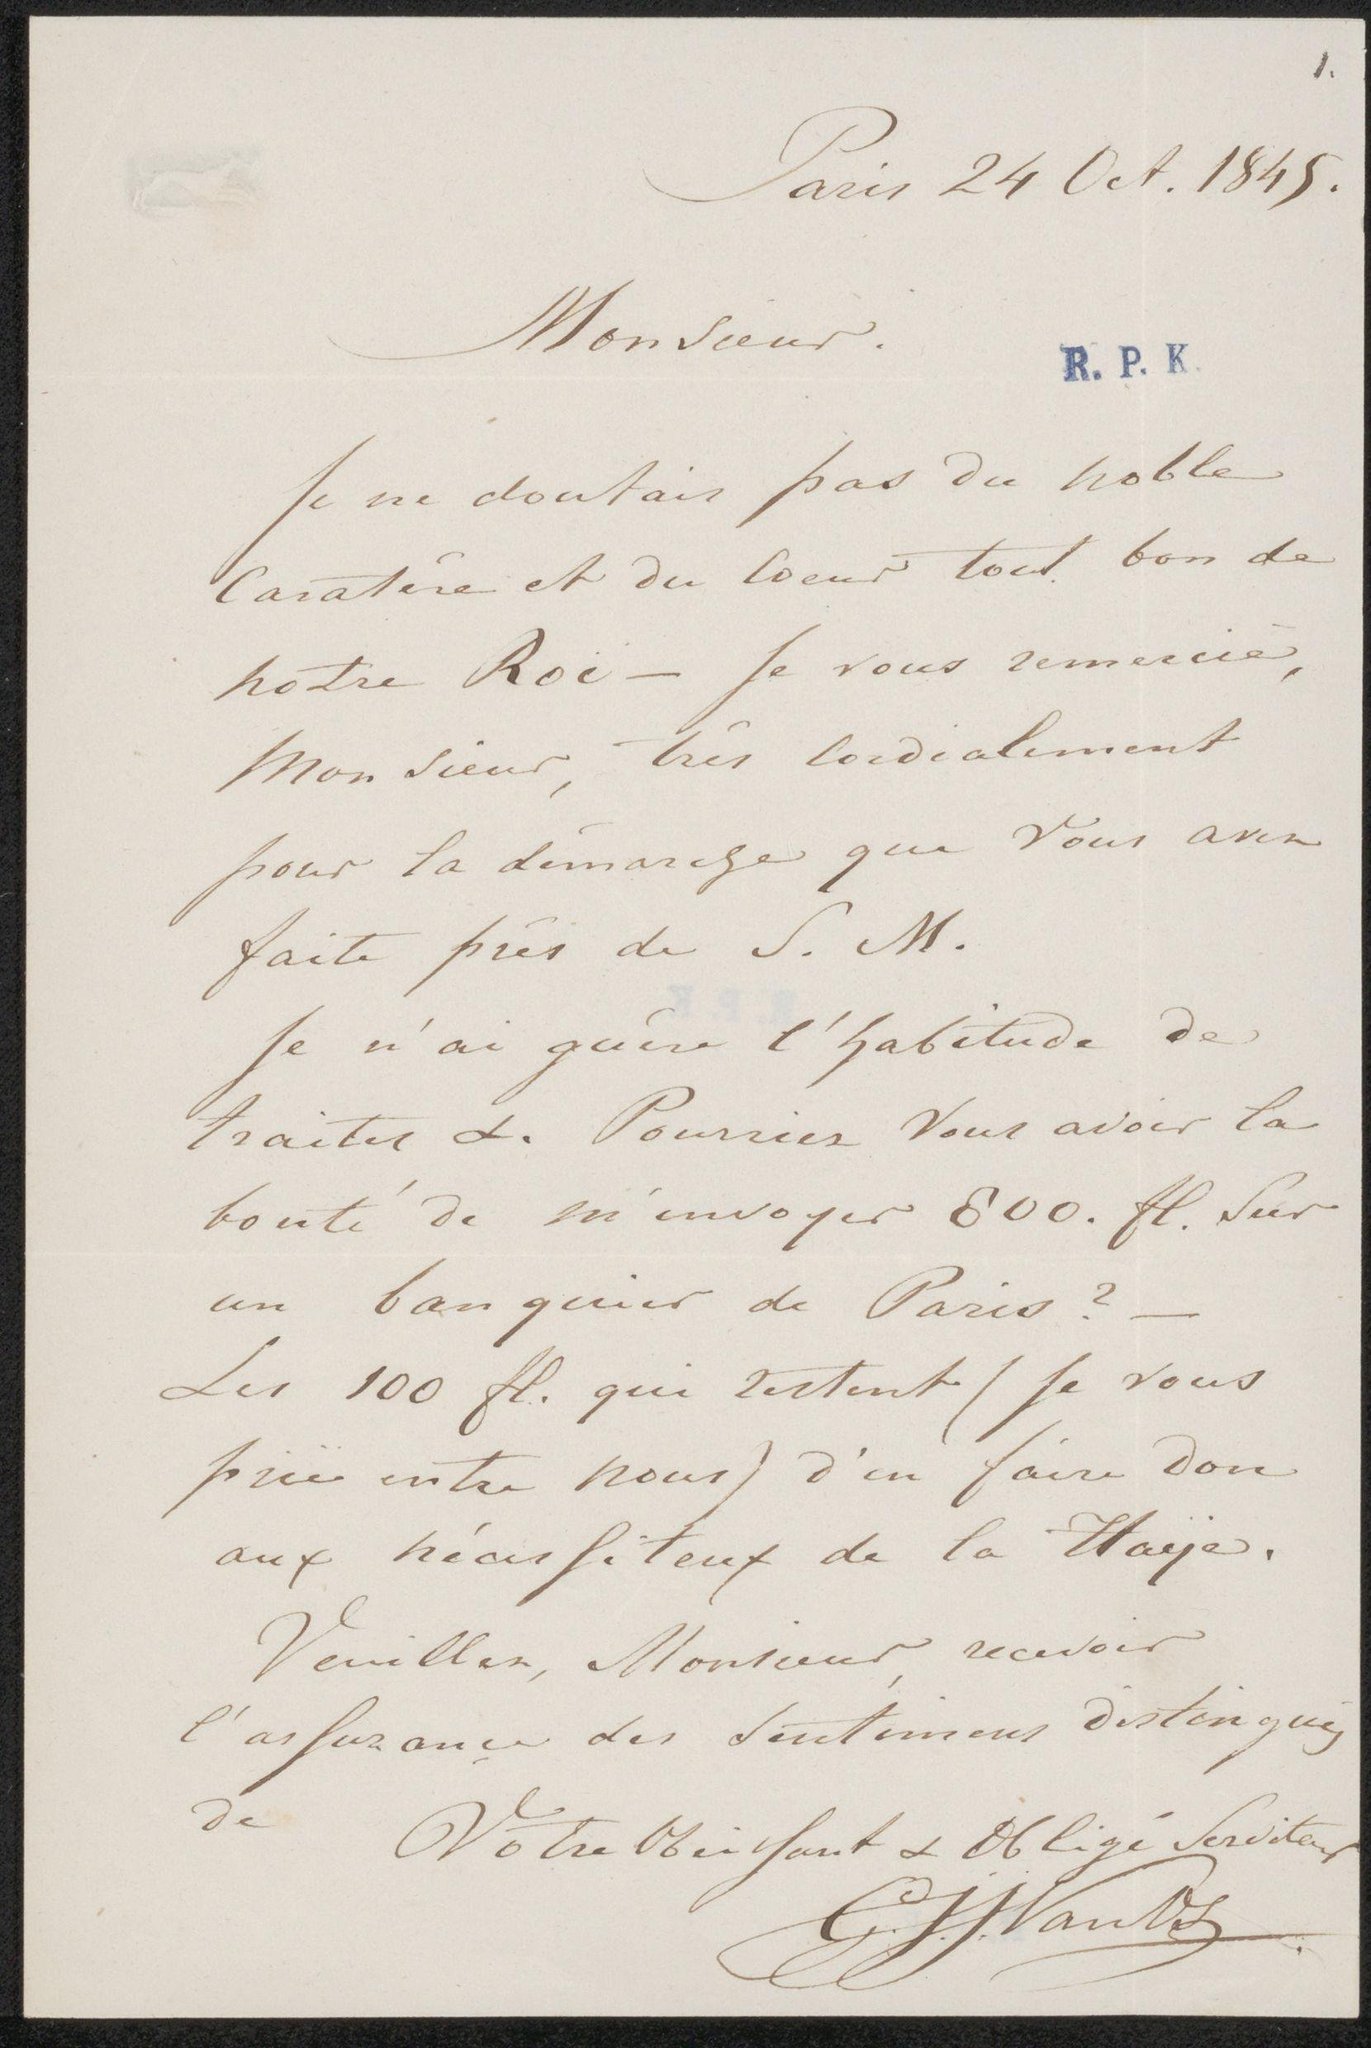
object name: letter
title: Brief aan anoniem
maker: georgius jacobus johannes van os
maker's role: draughtsman, painter, print maker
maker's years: 1782-1861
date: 1845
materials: ink, paper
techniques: pen, writing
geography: paris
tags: money, the hague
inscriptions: collector's mark: Lugt 2233, check stamp